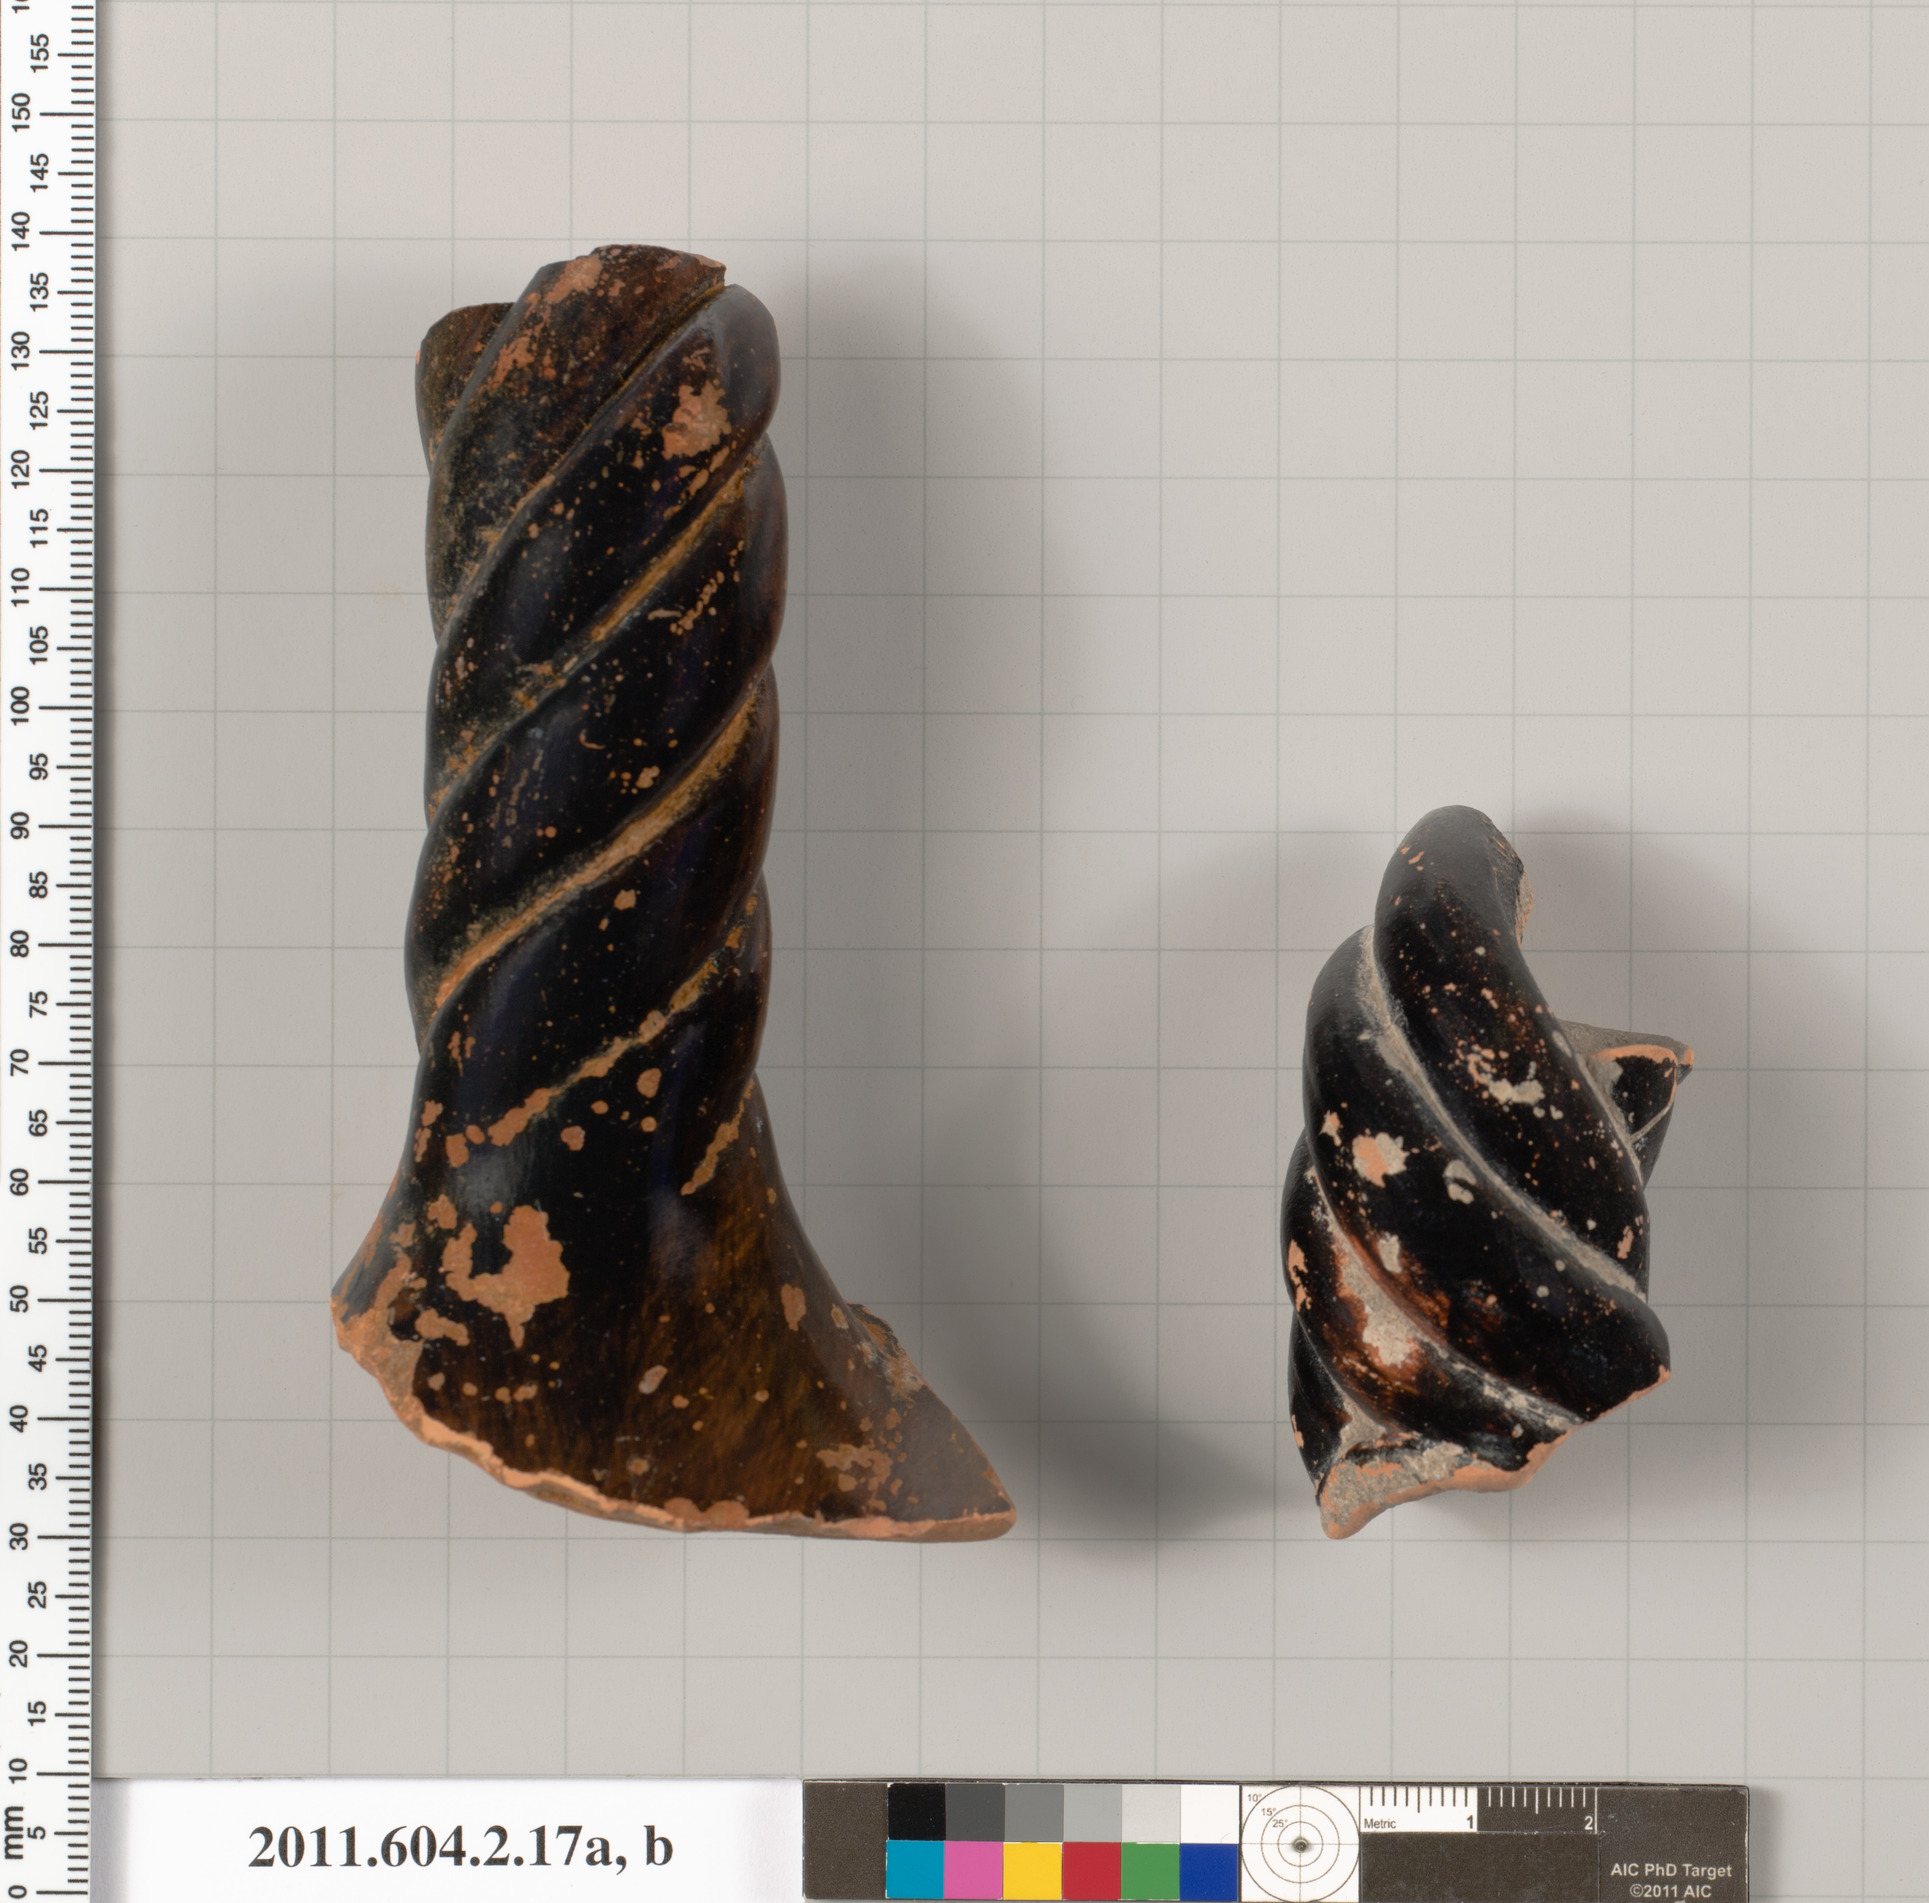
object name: neck amphora fragment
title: Terracotta fragments of neck-amphorae (jars)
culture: greek, attic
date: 460-450 BCE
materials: terracotta